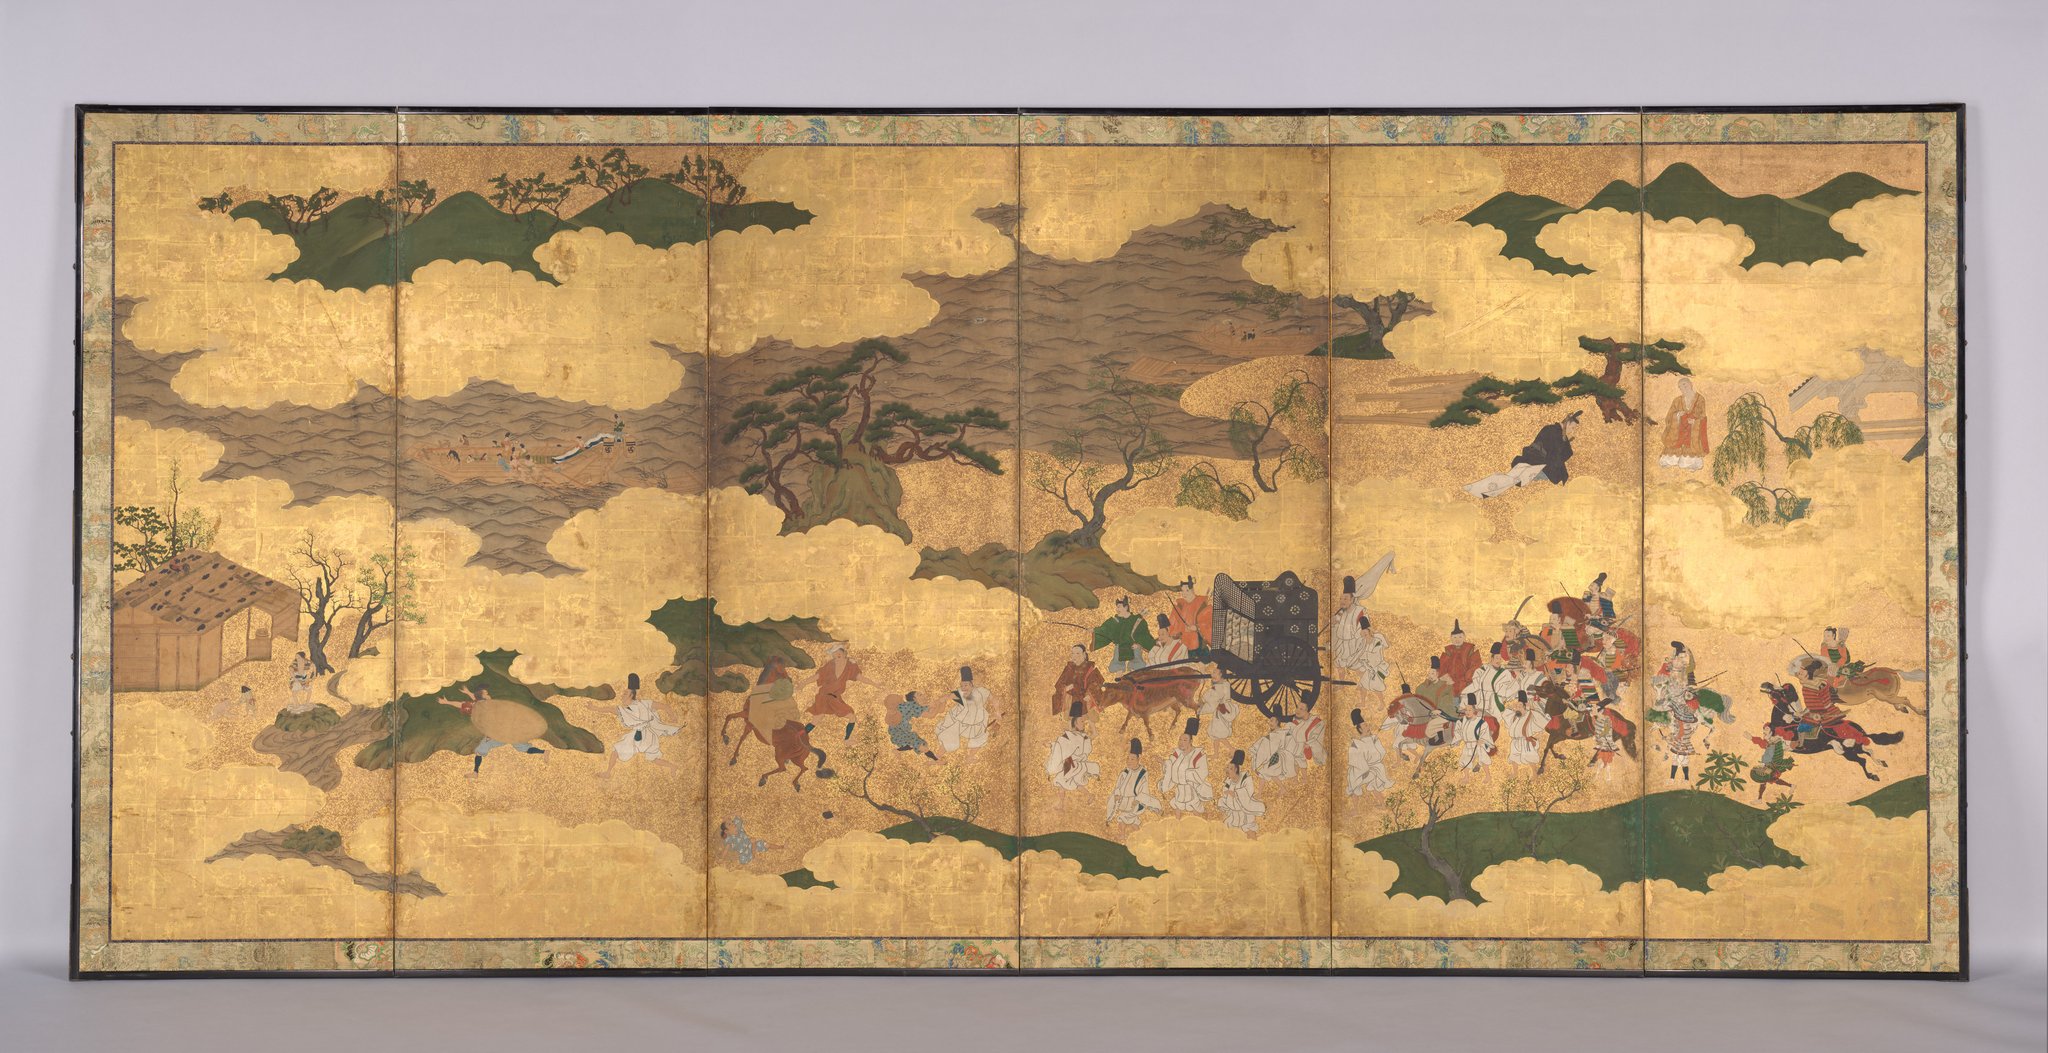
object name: screen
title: Sugawara no Michizane Being Exiled to Dazaifu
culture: japanese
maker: unidentified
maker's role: artist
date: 1601-1633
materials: gold leaf, ink, panel, paper